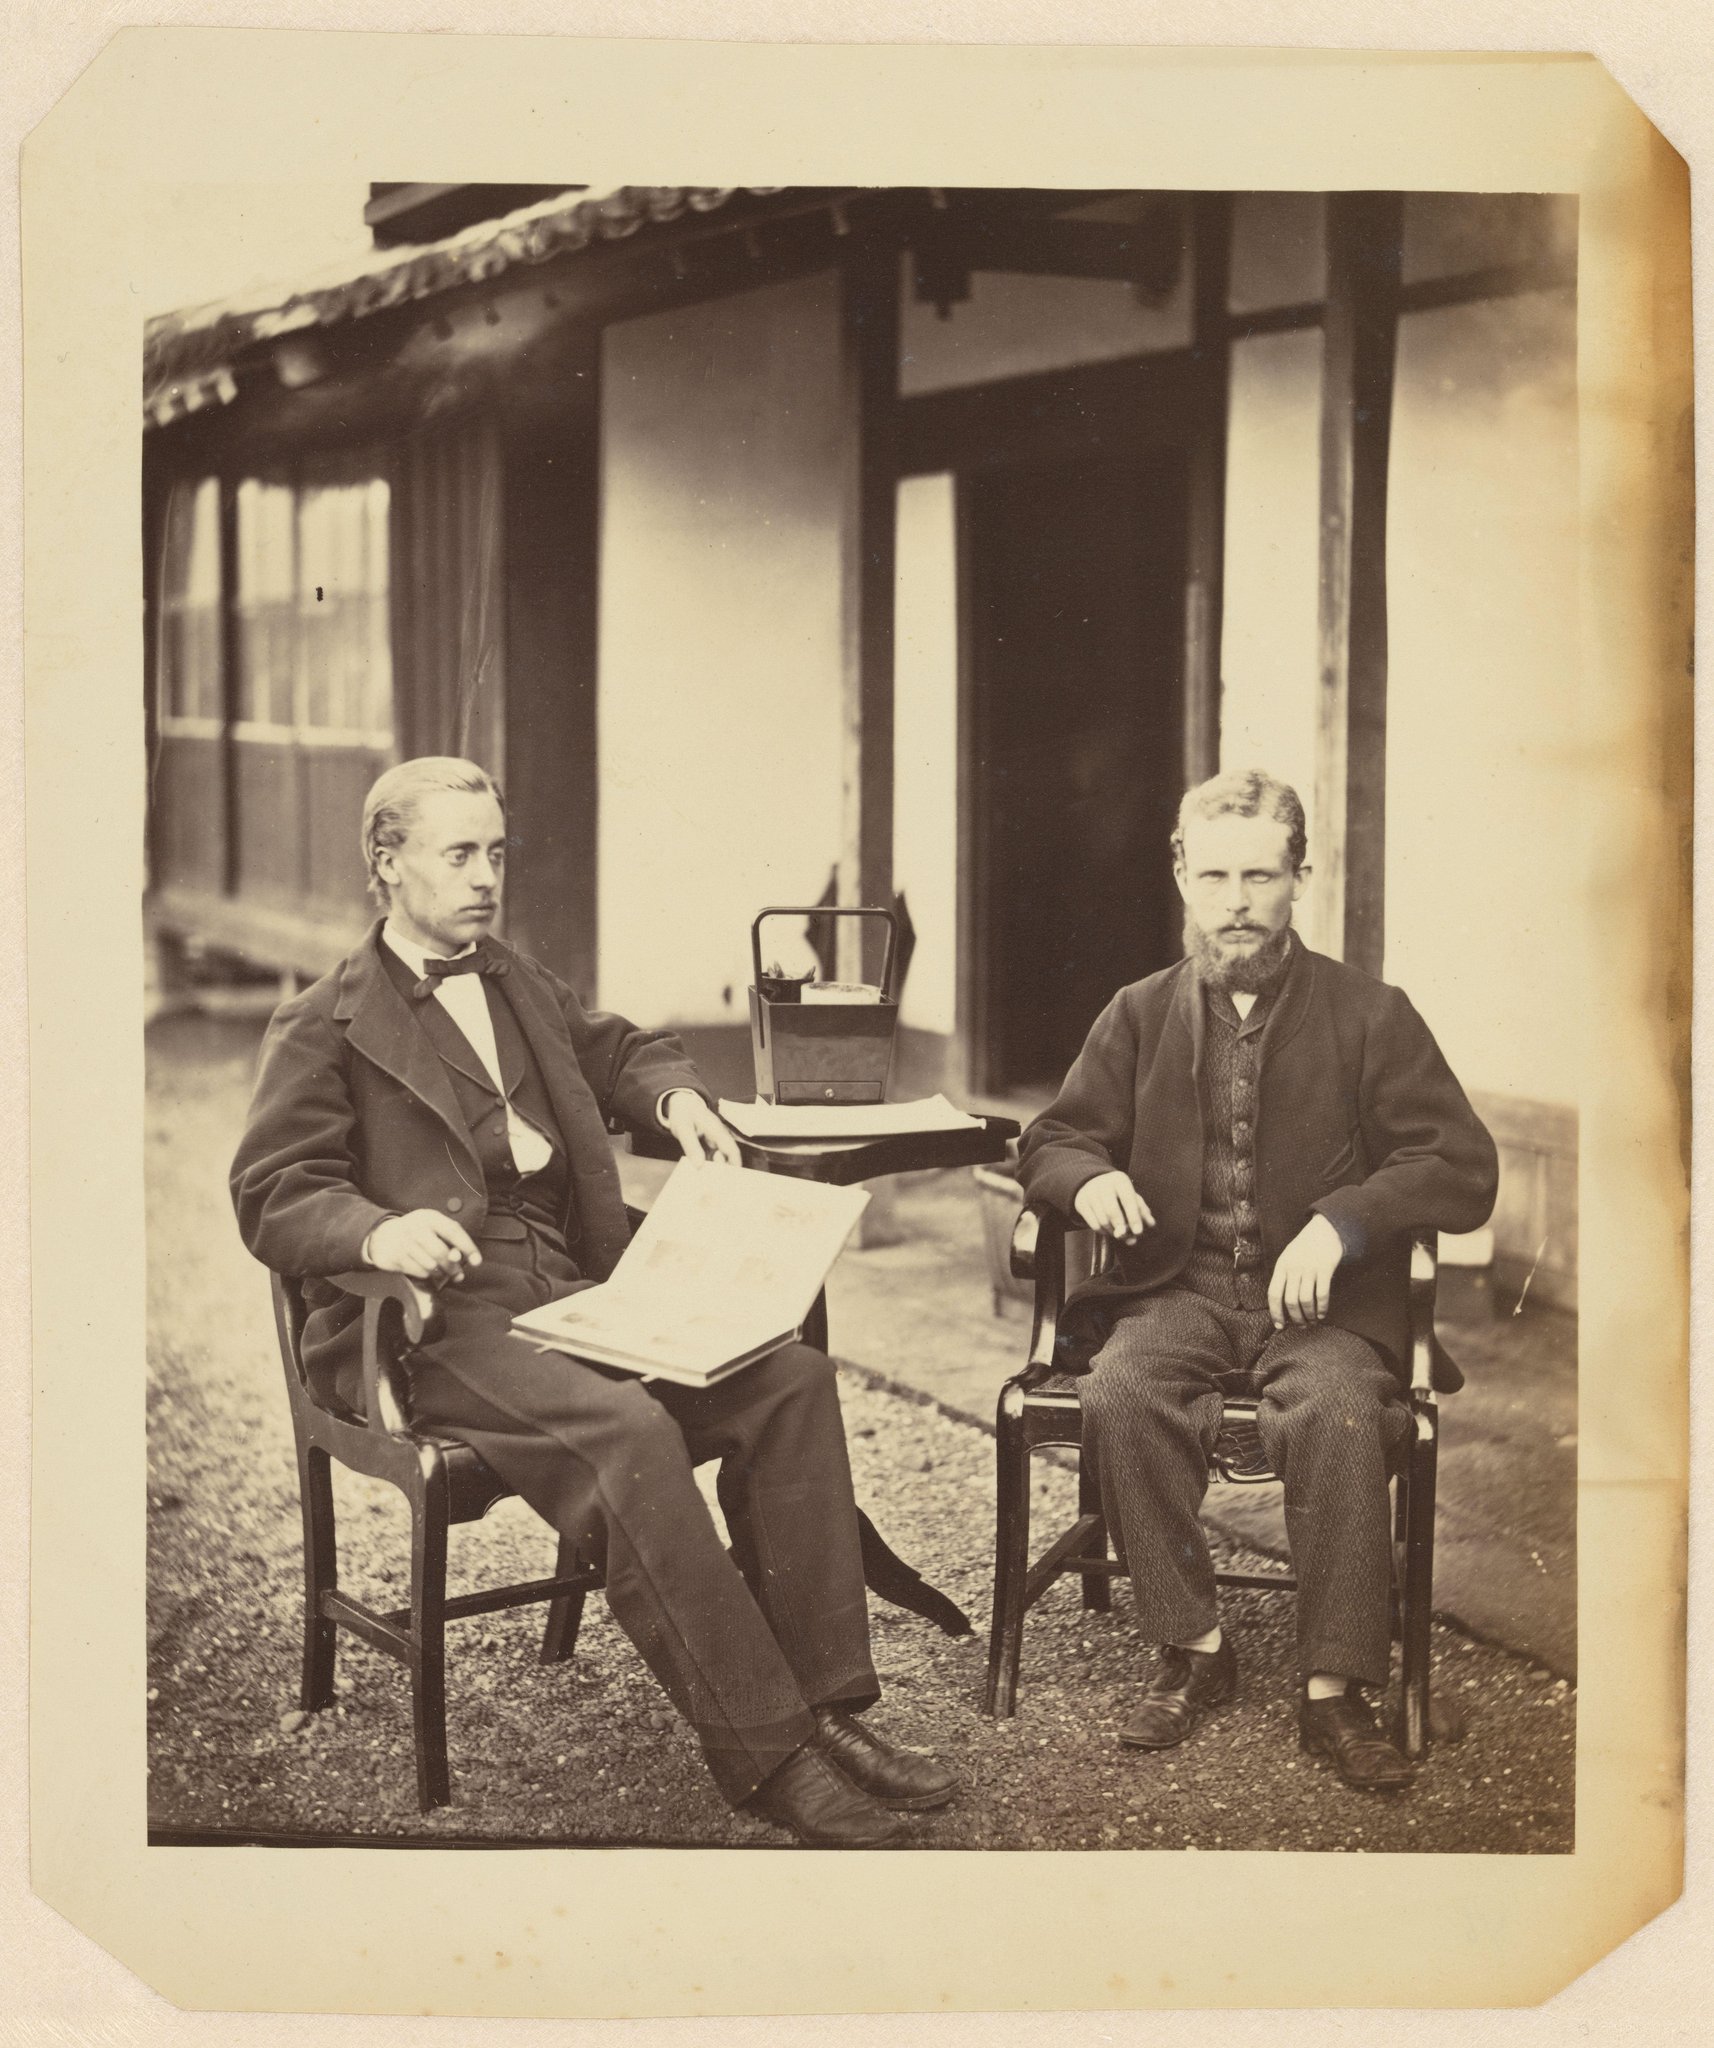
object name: photograph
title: Group portrait of two men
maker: antoon bauduin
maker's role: amateurfotograaf, hoogleraar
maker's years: 1820-1885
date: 1862-1866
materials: paper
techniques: albumen print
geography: japan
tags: sitting figure, japan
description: In a letter dated 1867, Albert complained that he had had ‘not a day without guests who stayed the night’ in six years: ‘I’m fed up & I should like nothing better than rest & freedom, but when?’ In addition to his job with the trading company, Albert was also the Dutch consul. This would explain why so many people stayed with him.